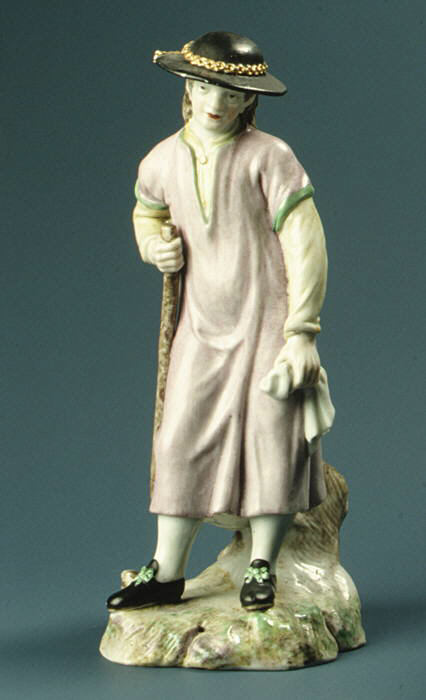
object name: figure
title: Norwegian Peasant (Bridegroom from Fanøe)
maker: royal porcelain manufactory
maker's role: manufactory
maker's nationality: danish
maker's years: 1775-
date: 1780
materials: hard paste porcelain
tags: men,farmers